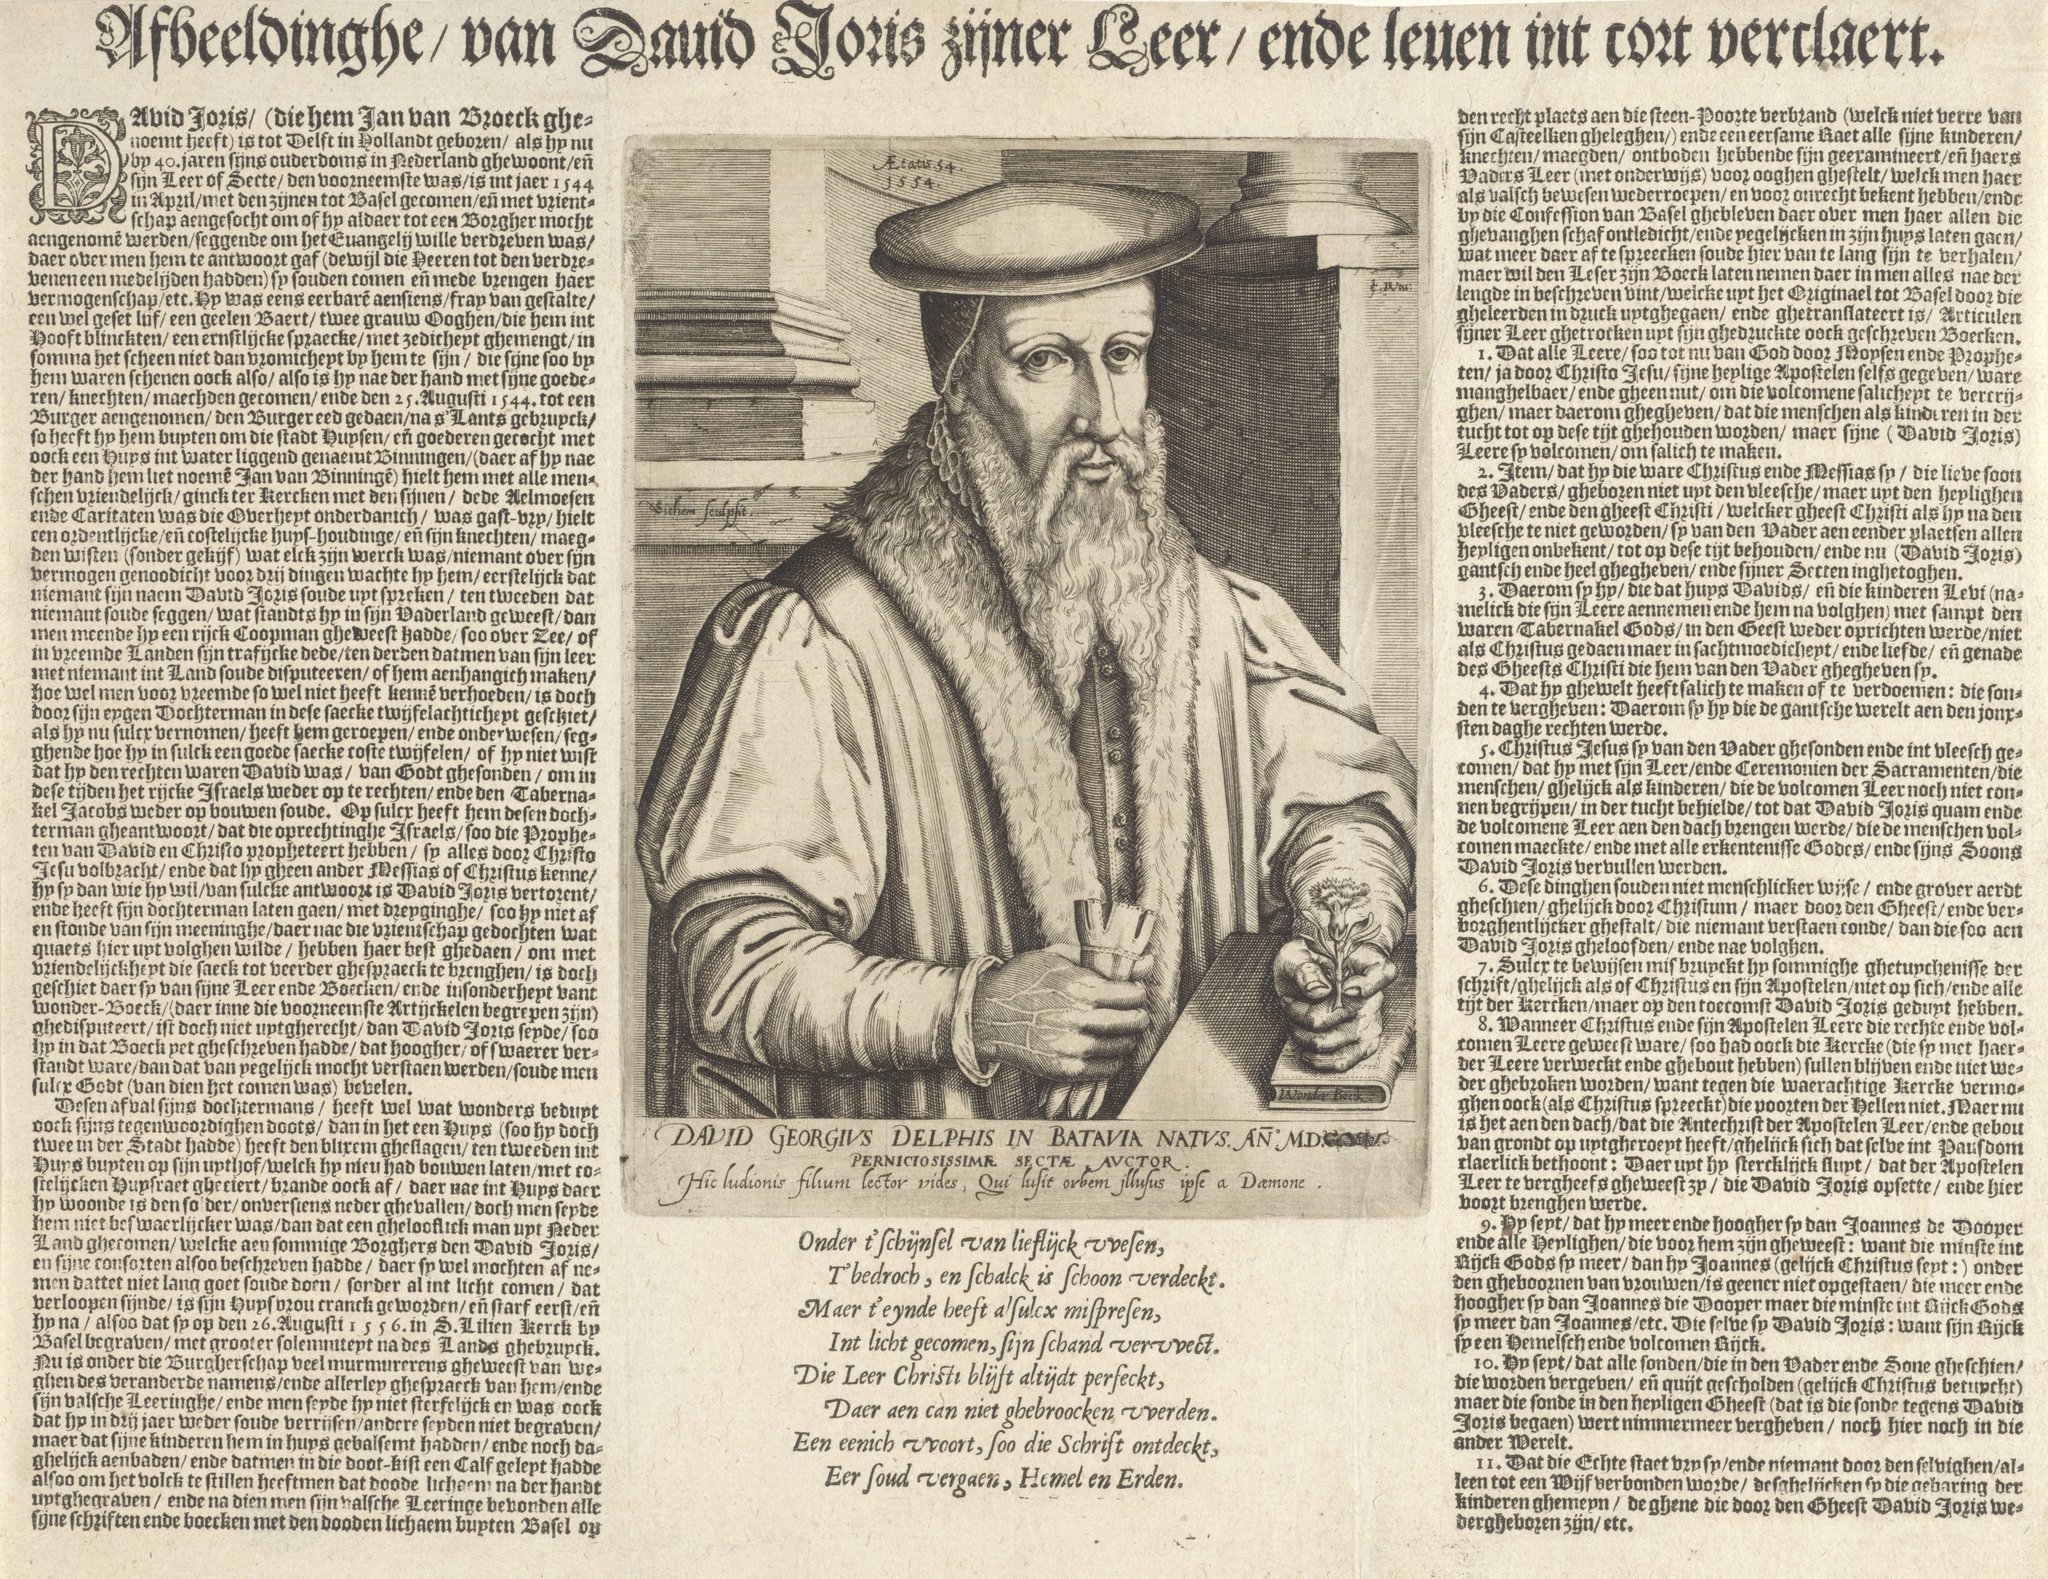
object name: print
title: David Georgius Delphis in Batavia natus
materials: paper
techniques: engraving, etching, letterpress printing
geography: amsterdam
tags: bruges, david jorisz.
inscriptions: collector's mark: Lugt 2228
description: Portret van David Jorisz., aan een tafel, waarop een exemplaar van het door hem geschreven 'Wonderboeck' ligt. Hij laat zijn hand, waarin hij een anjer vasthoudt, rusten op het boek. In de andere hand heeft hij een handschoen. Boven zijn hoofd staat het jaartal 1554 en zijn leeftijd vermeld. Onder het portret een drie-regelig onderschrift in het Latijn. Rondom de prent een Nederlandstalige levensbeschrijving in boekdruk.